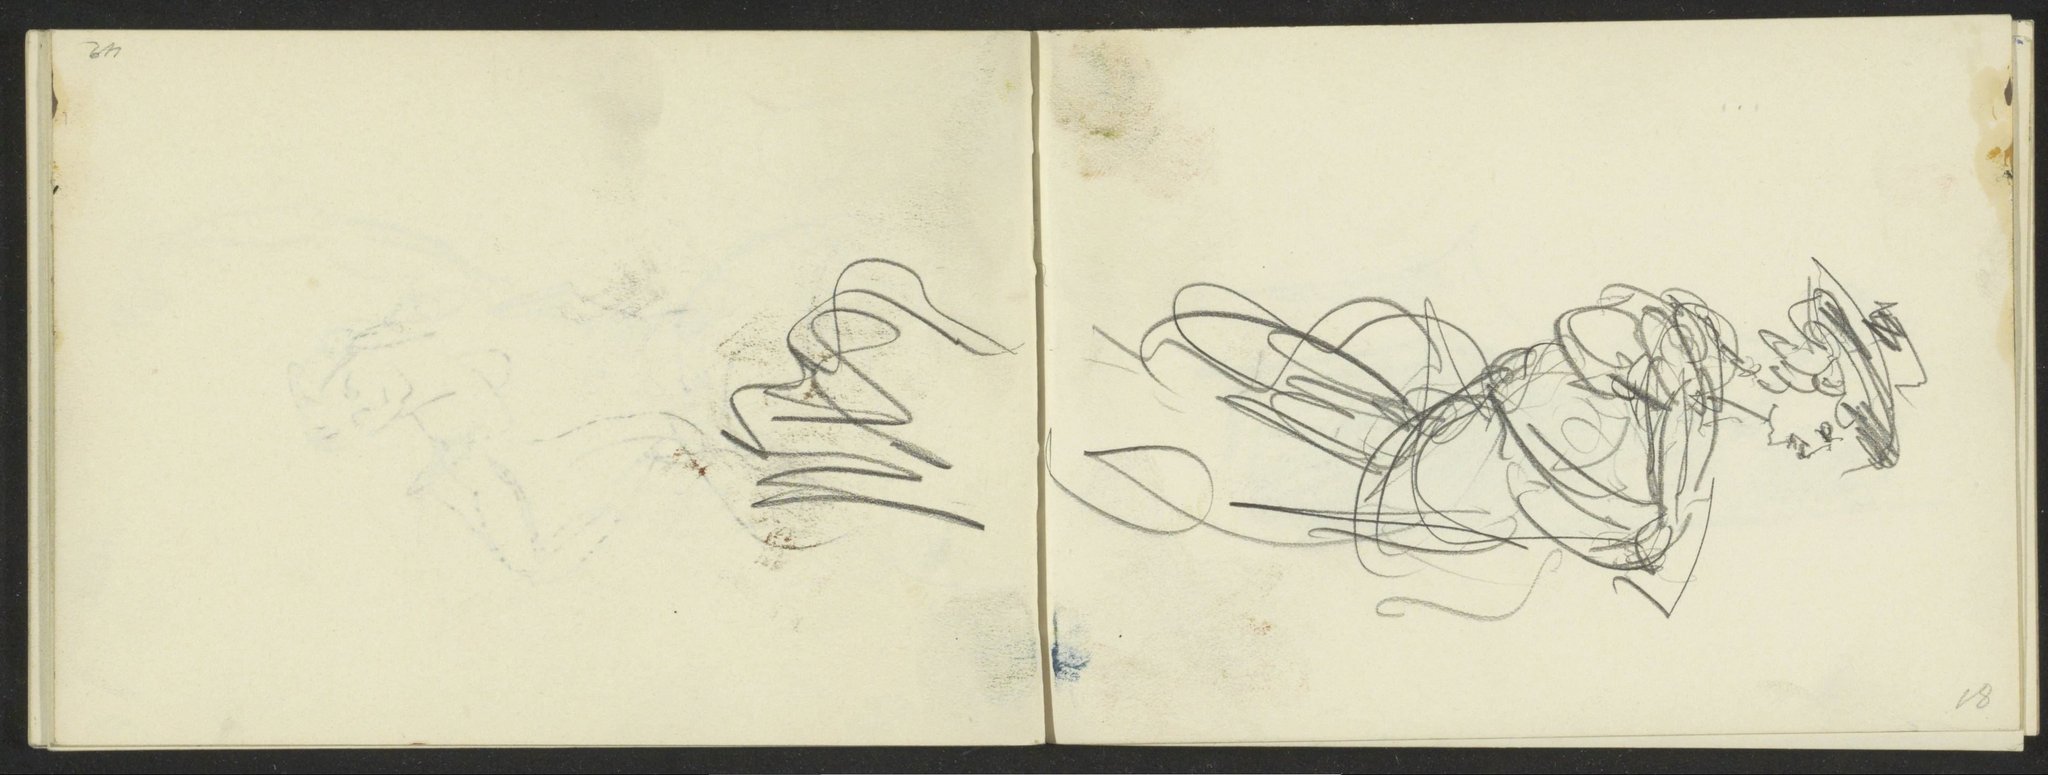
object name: sketchbook leaf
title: Staande vrouw met hoed, in profiel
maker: isaac israels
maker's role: draughtsman, painter, print maker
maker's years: 1865-1934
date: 1875-1934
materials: paper, pencil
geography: the hague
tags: head-gear: hat (+ women's clothes), adult woman (+ standing)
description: Blad 17 verso en blad 18 recto uit schetsboek LVII met 29 bladen.